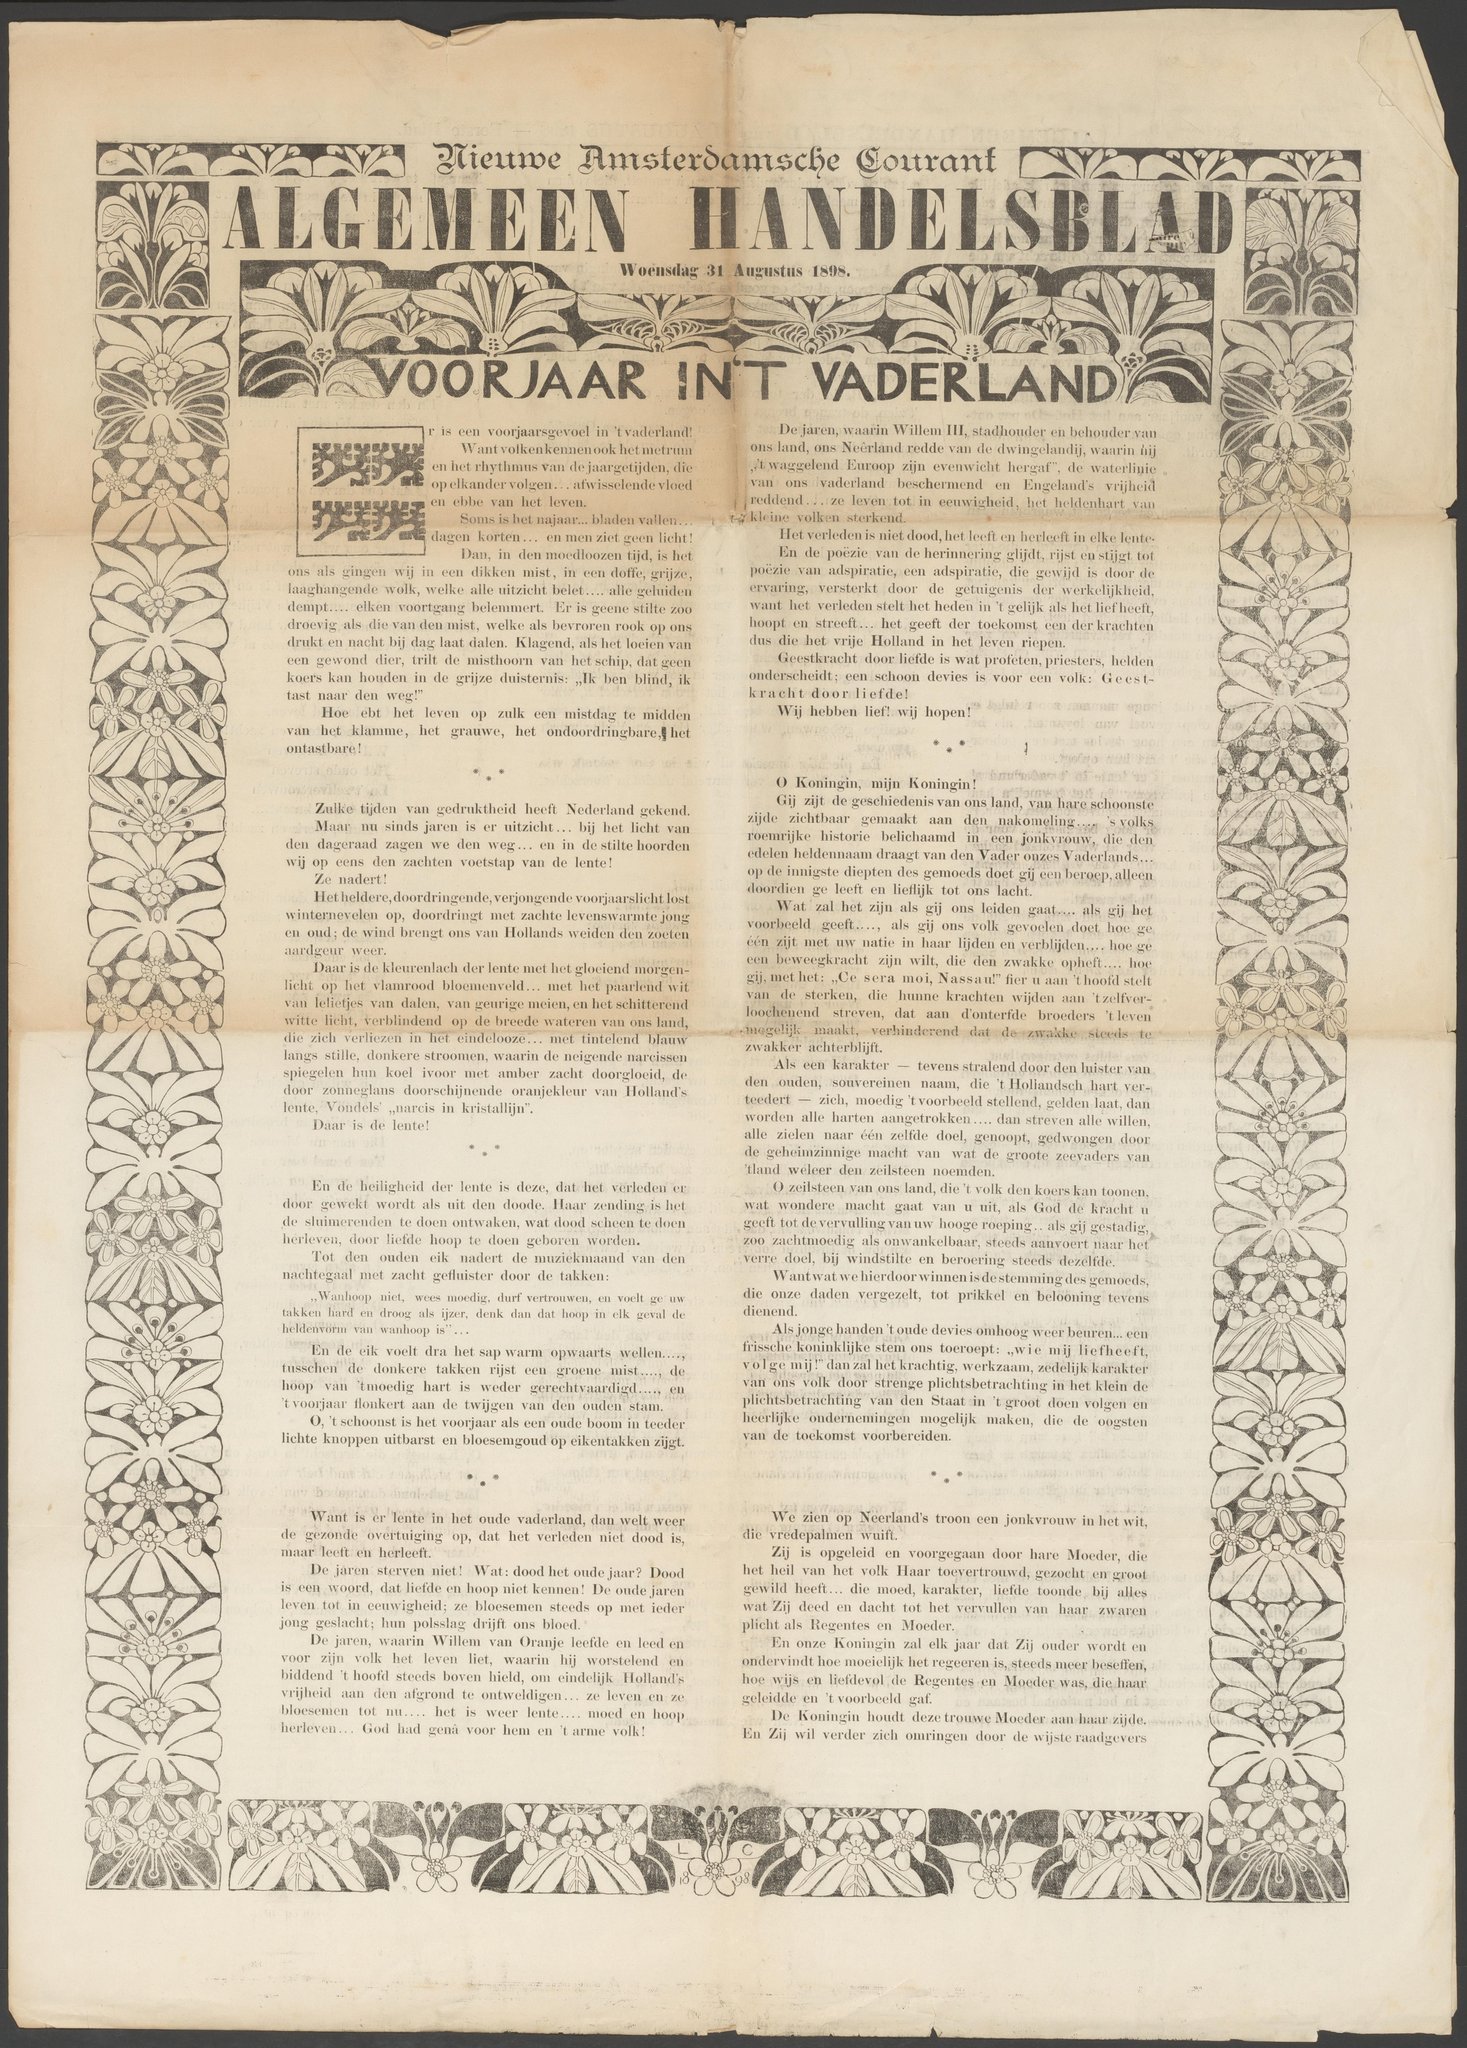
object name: newspaper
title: Algemeen Handelsblad, 31 augustus 1898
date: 1898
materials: paper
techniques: printing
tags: the hague, print maker, wilhelmina of the netherlands, newspaper, news-sheet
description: Exemplaar van de Nieuwe Amsterdamsche Courant / Algemeen Handelsblad van 31 augustus 1898. Dubbelbladig, op alle zijden bedrukt. Onderwerpsrubrieken binnen de Atlas Zeden en Gewoonten: Regeering, Officieele Nieuwsbladen.